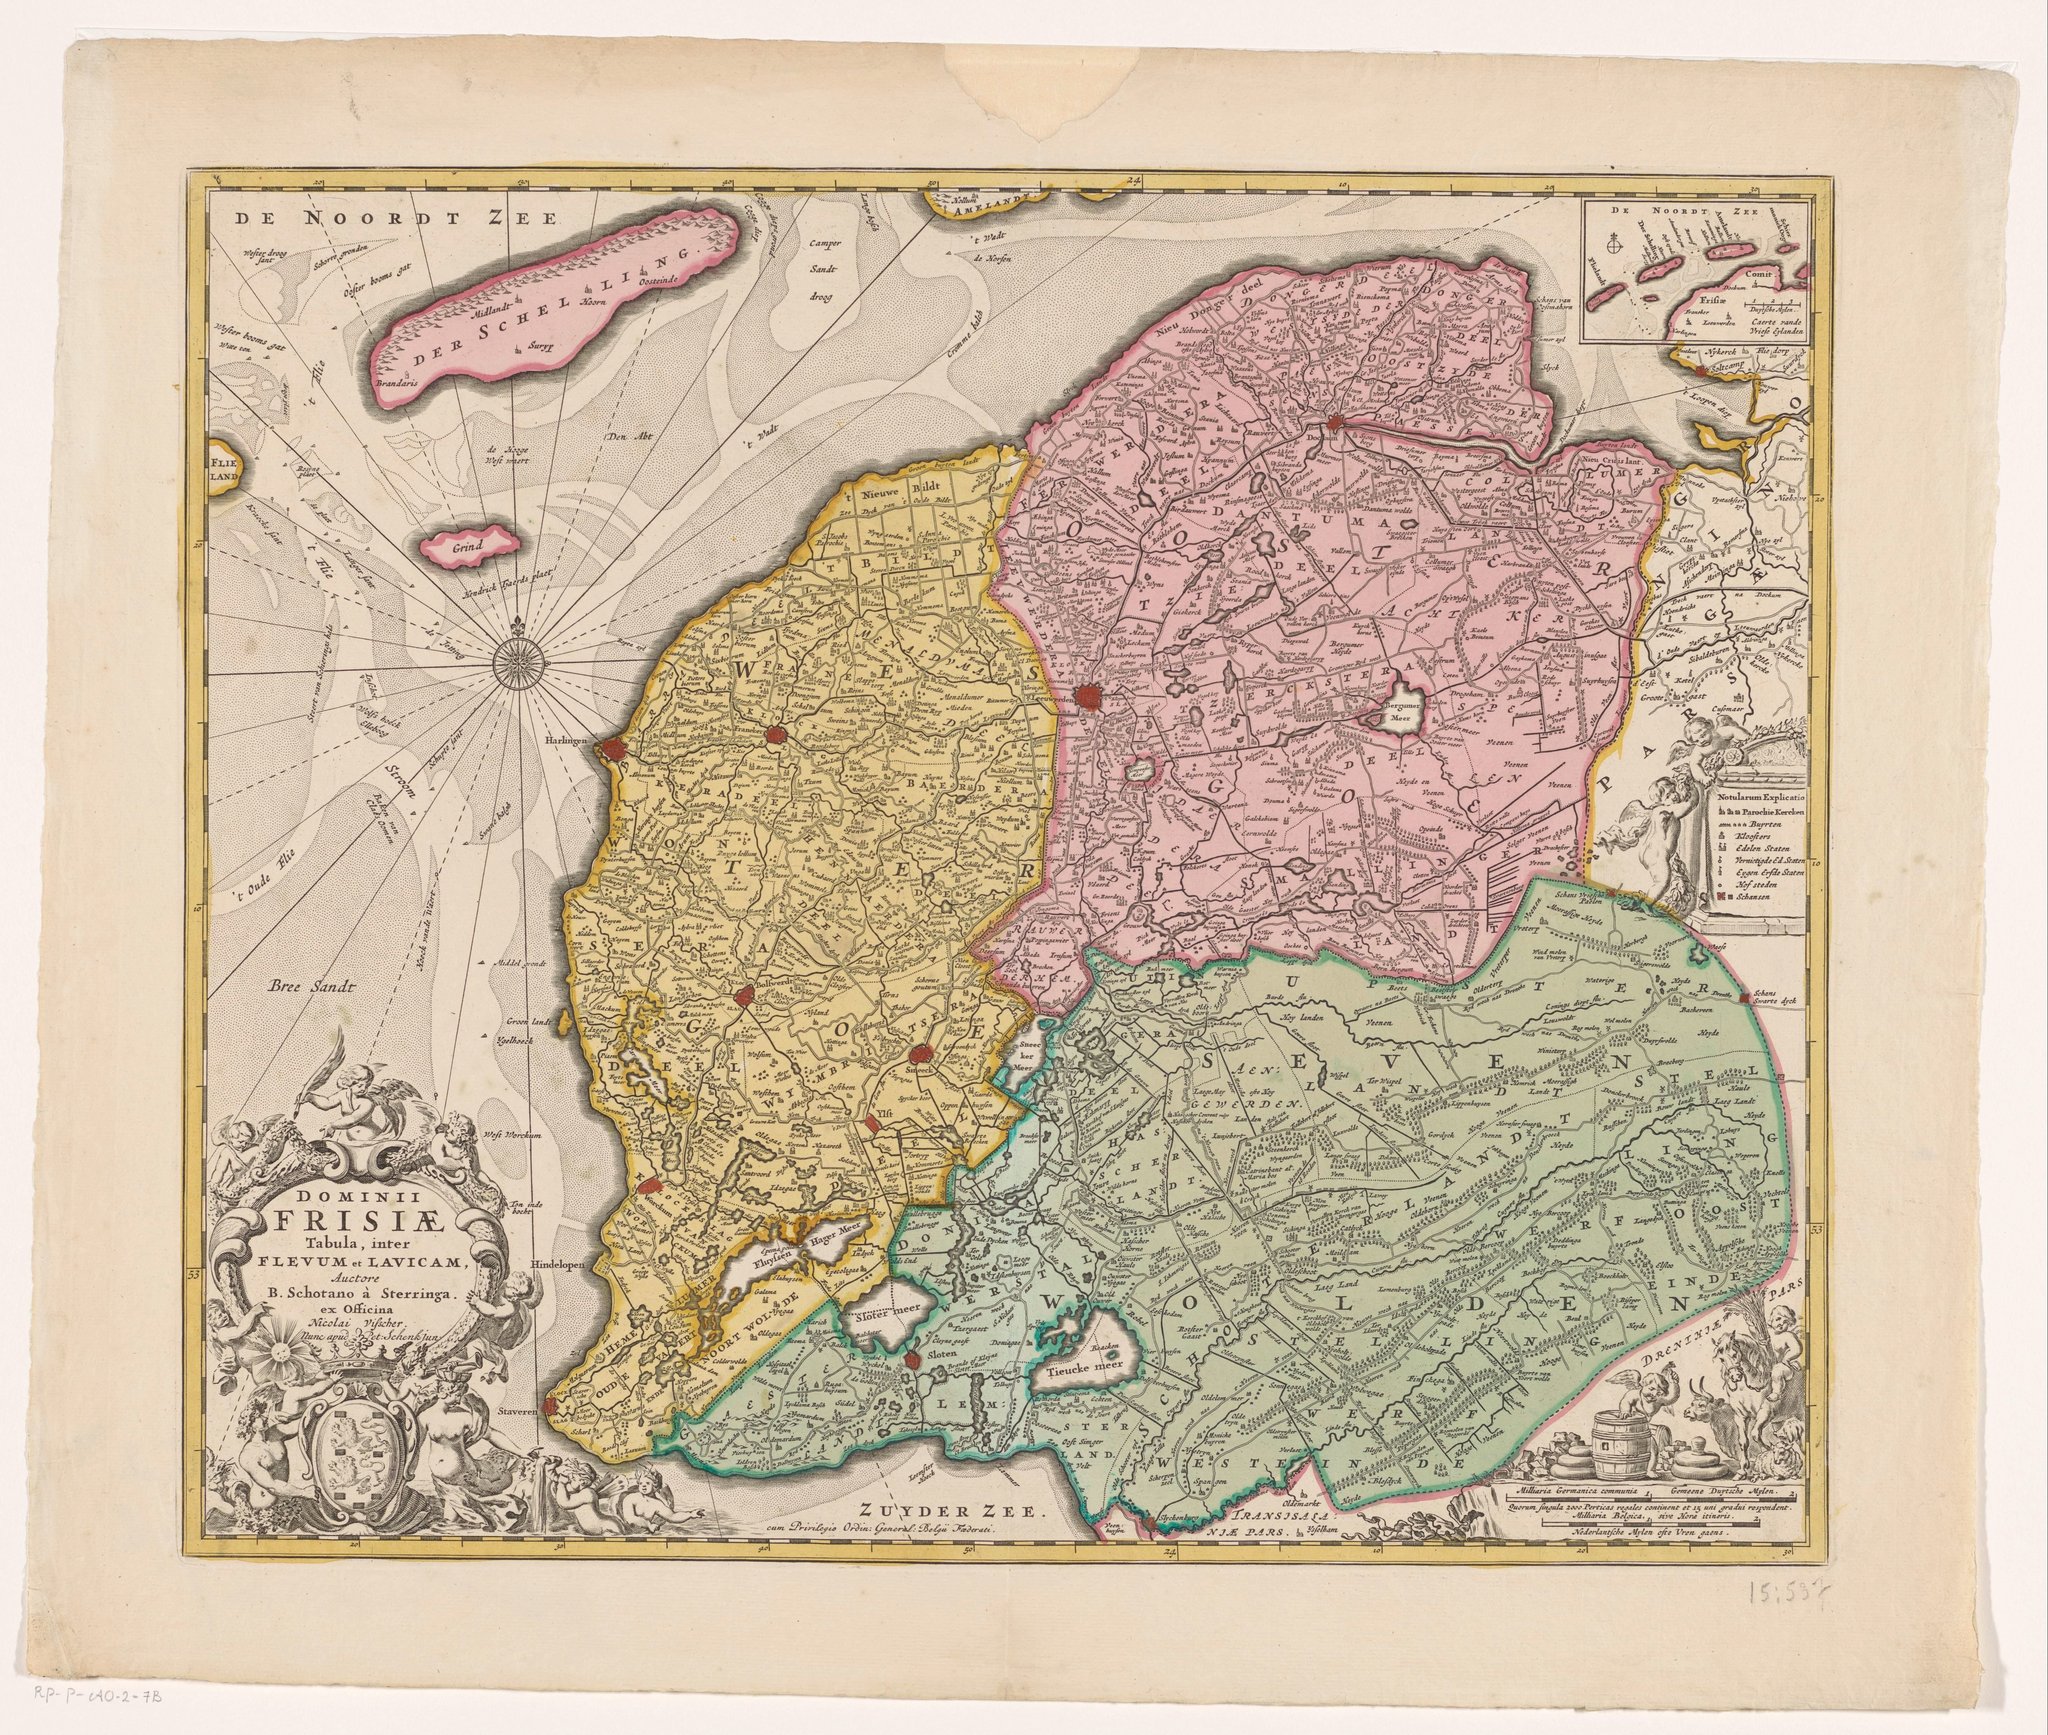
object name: print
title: Dominii Frisiae tabula, inter Flevum et Lavicam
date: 1775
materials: paper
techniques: engraving, etching, hand coloring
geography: amsterdam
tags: coat of arms (as symbol of the state, etc.), maps of separate countries or regions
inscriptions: collector's mark: Lugt 2228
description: Linksonder titelcartouche met daaronder het wapen van Friesland en daaromheen putti en zeewezens. Rechtsboven een kleine inzet met de Waddeneilanden Vlieland, Ameland, Terschelling en Schiermonnikoog. Rechtsmidden een legenda. Rechtsonder putti met voorwerpen van landbouw en veeteelt: boter, kaas, graan en vee. Daaronder drie schaalstokken: Milliaria Germanica communia / Gemeene Duytsche mylen, Milliaria Belgia sive hore itineris, Nederlantsche mylen ofte uren gaens. Gradenverdeling langs de randen.